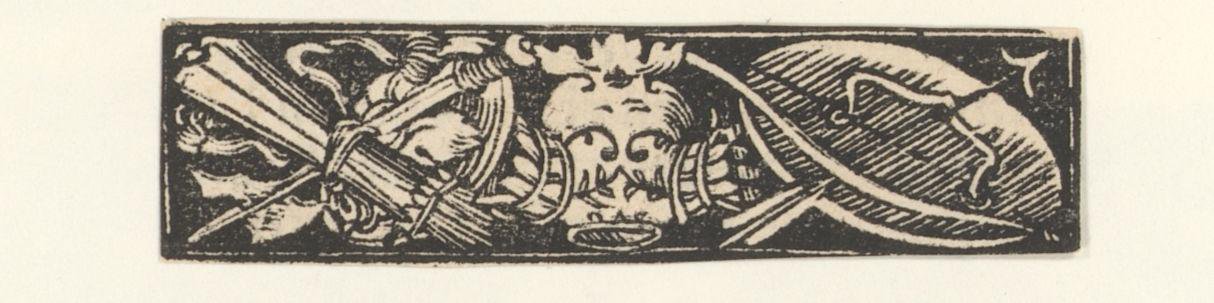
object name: album leaf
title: Ornamenten met pijl en boog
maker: Anonymous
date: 1514-1532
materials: paper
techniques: letterpress printing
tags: 'tropaion', i.e. decorative ornament ~ weapons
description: Deze prent is gebruikt als ornament in: Petrarca, Francesco. Von der Artzney bayder Glück, des guten und widerwertigen: unnd weß sich ain yeder inn Gelück und Unglück halten sol (...). Augsburg: Heinrich Steiner, 1532. Deze uitgave is ook bekend onder de titel 'Trostspiegel in Glück und Unglück'.